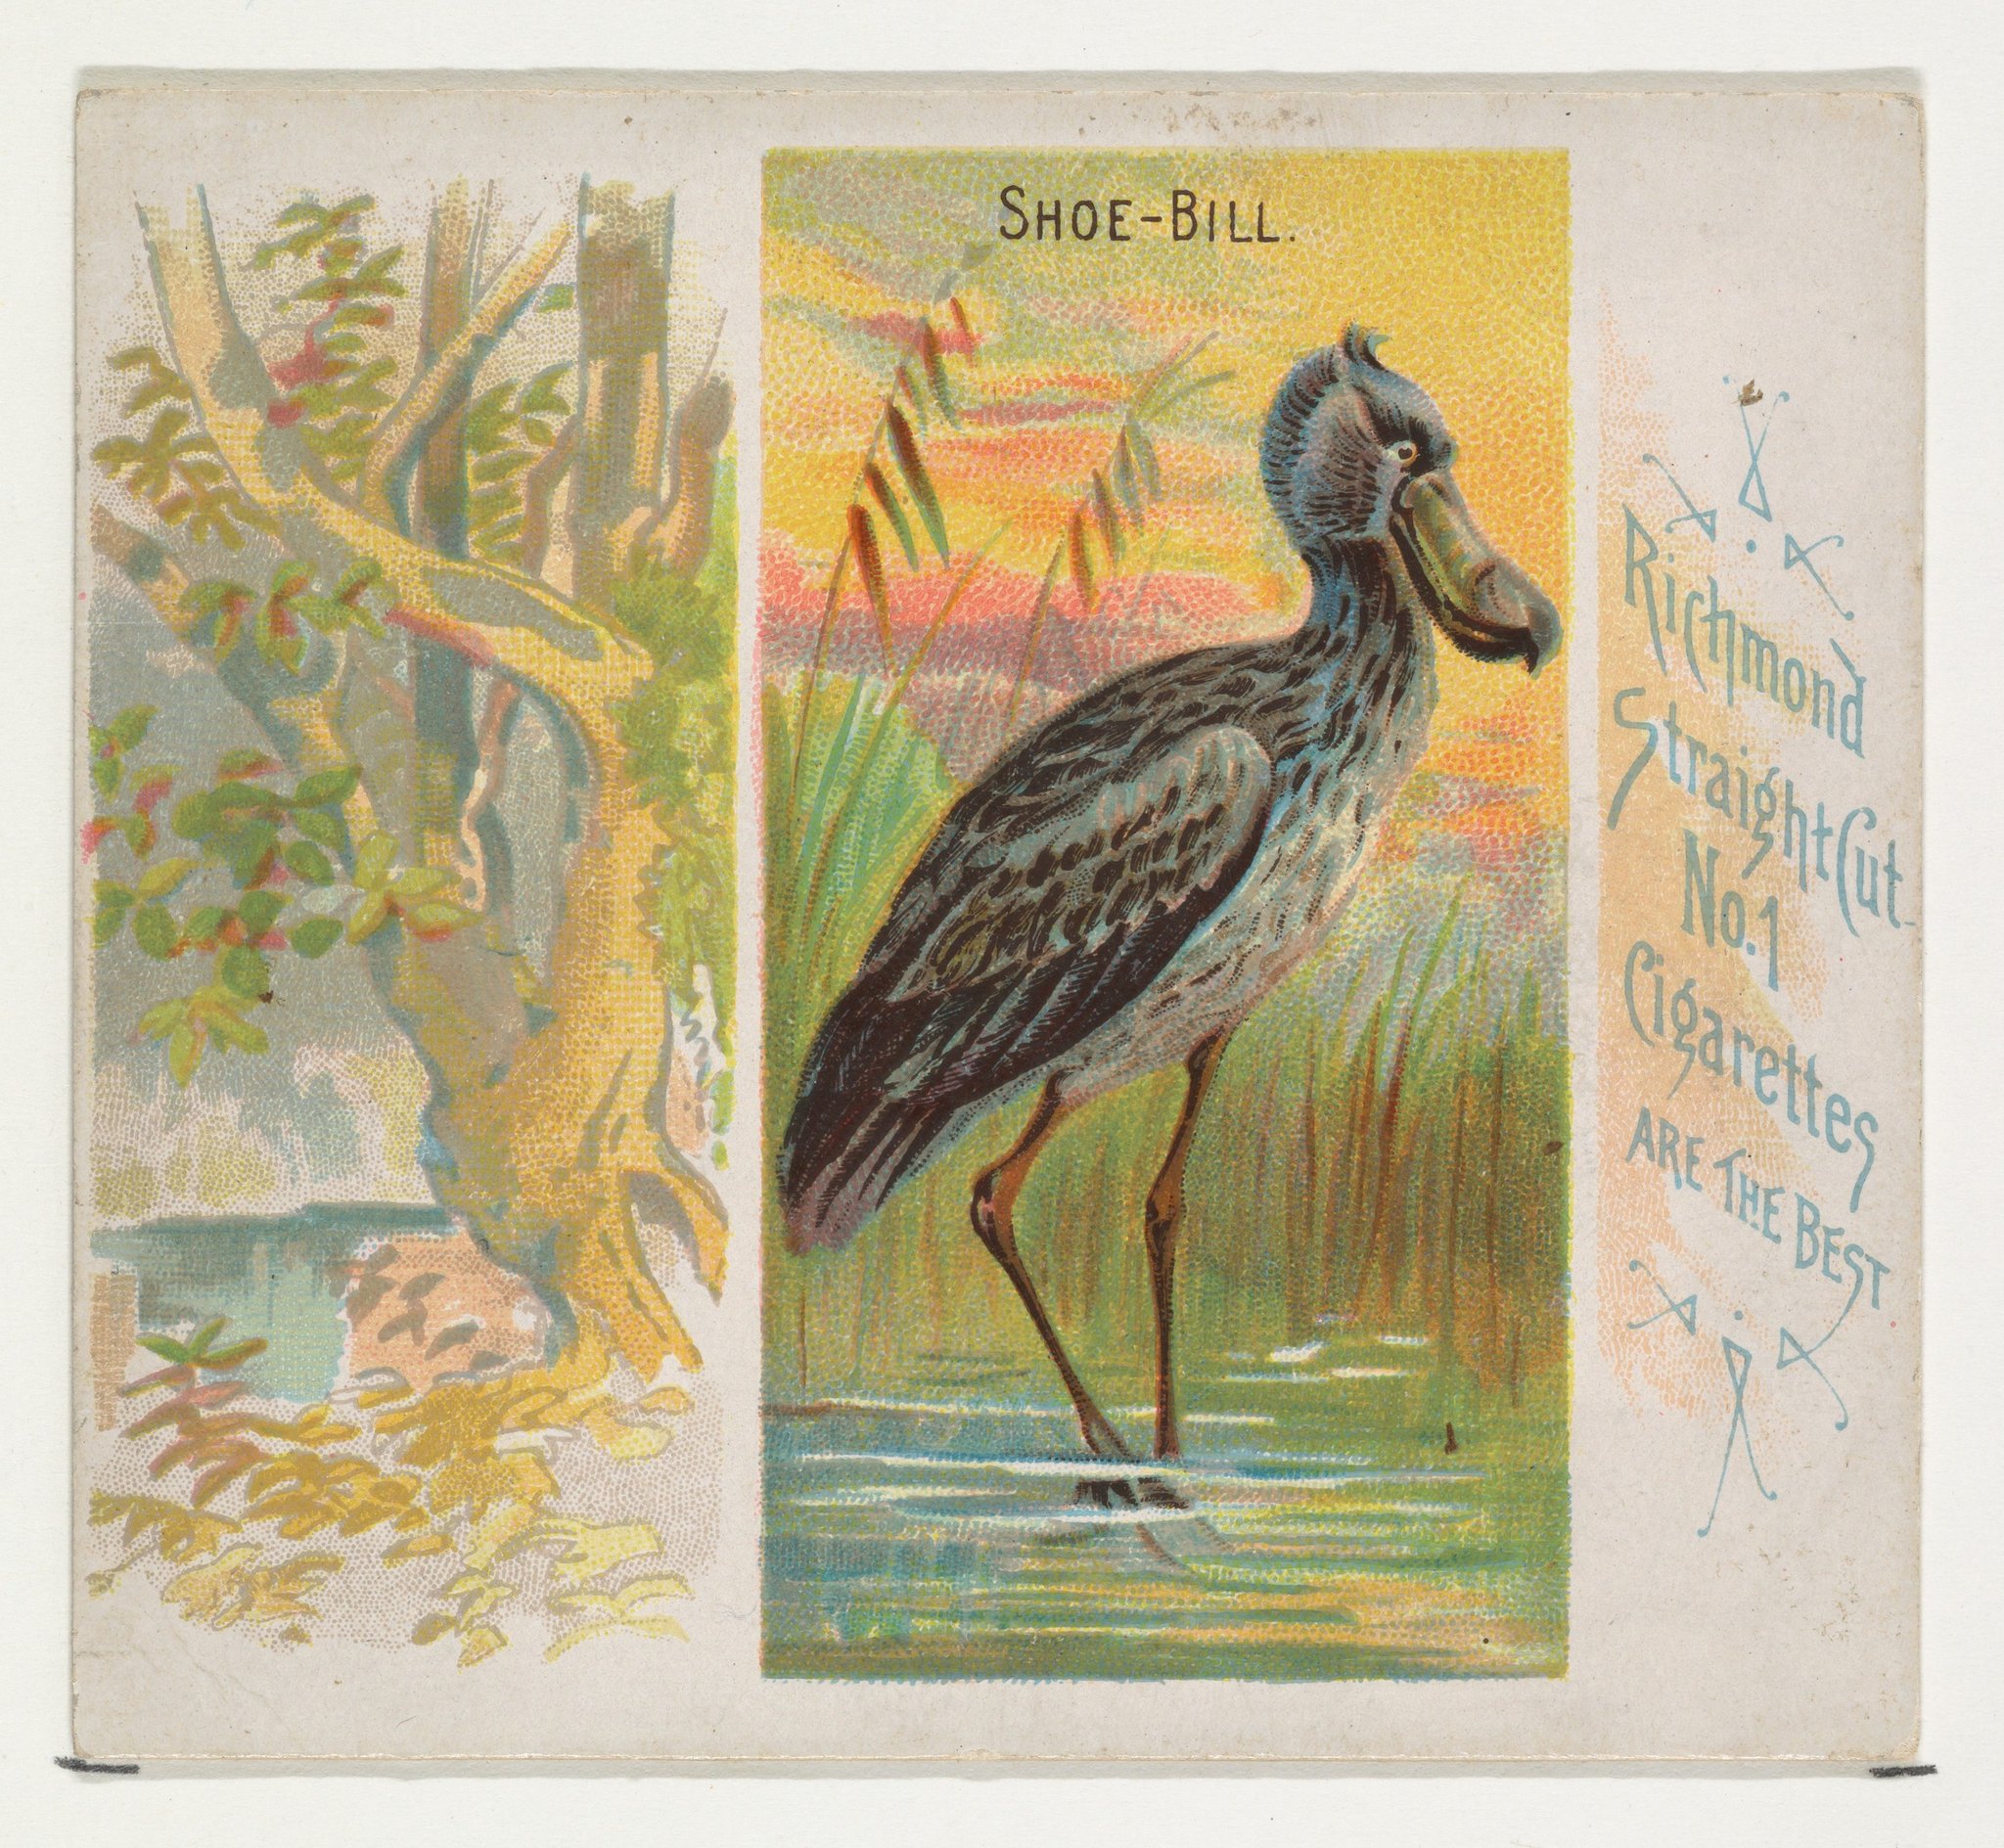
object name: print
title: Shoe-Bill, from Birds of the Tropics series (N38) for Allen & Ginter Cigarettes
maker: allen & ginter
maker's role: publisher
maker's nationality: american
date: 1889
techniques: color lithograph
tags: birds